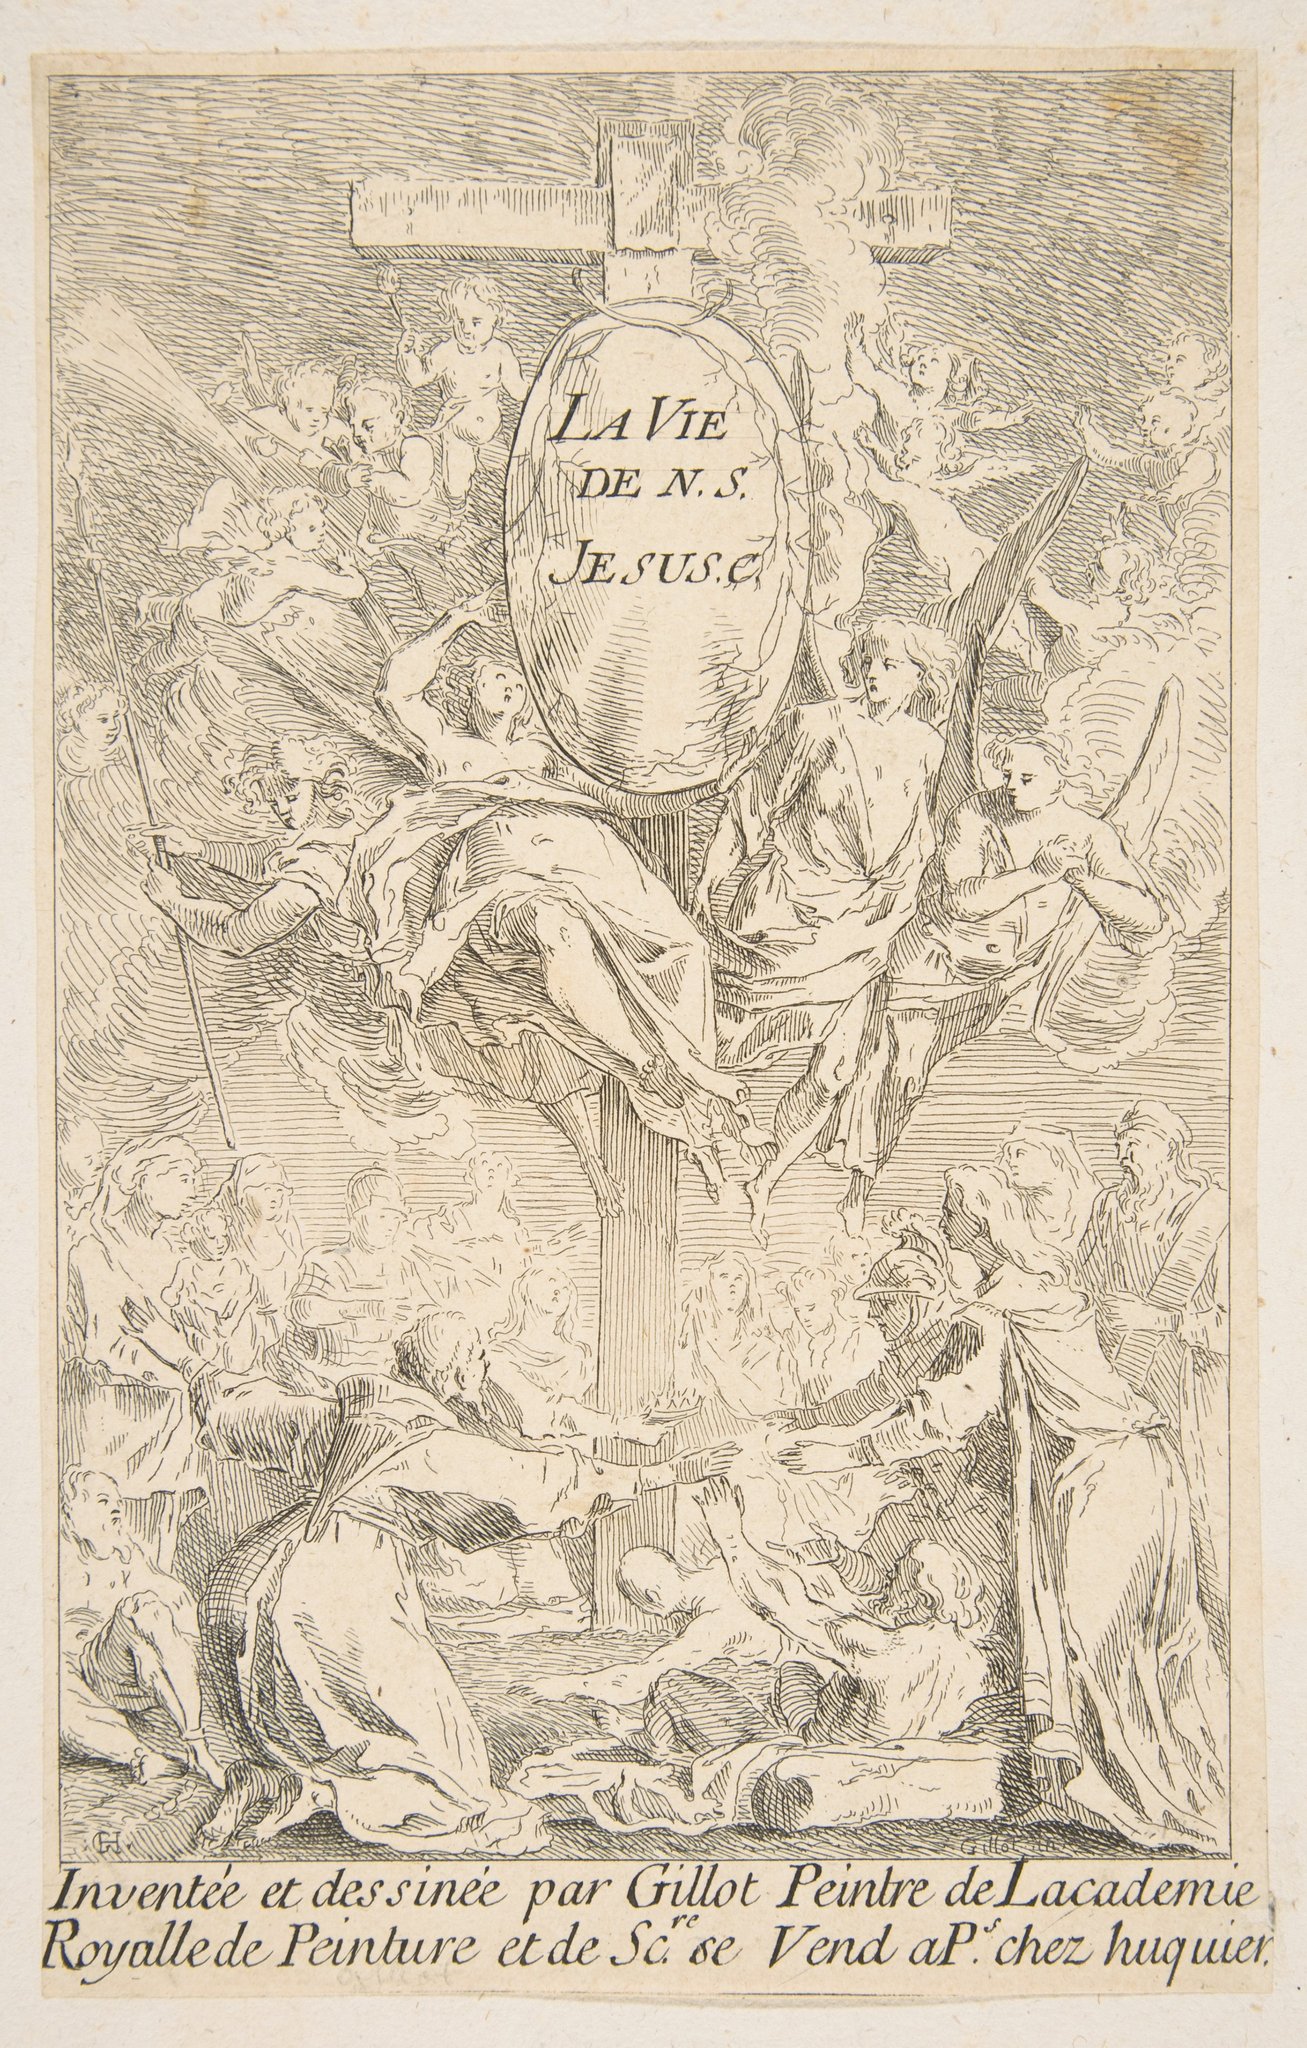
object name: print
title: Frontispiece to the series The Life of Christ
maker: claude gillot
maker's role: artist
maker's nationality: french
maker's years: 1673-1722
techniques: etching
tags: men,angels,christ,cross